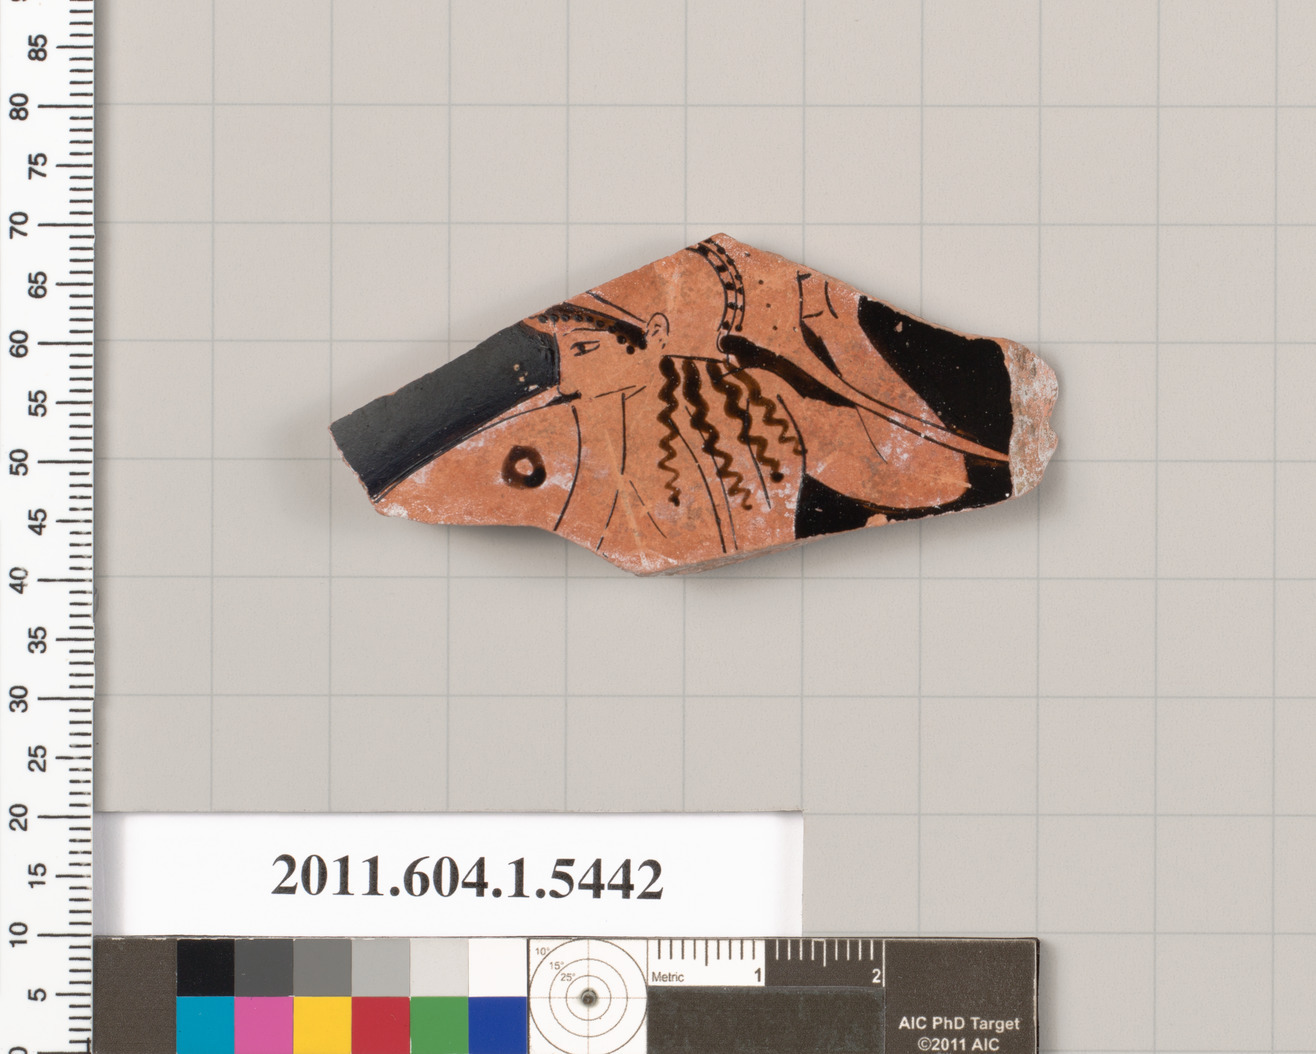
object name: kylix fragment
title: Terracotta fragment of a kylix (drinking cup)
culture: greek, attic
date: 475-451 BCE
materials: terracotta